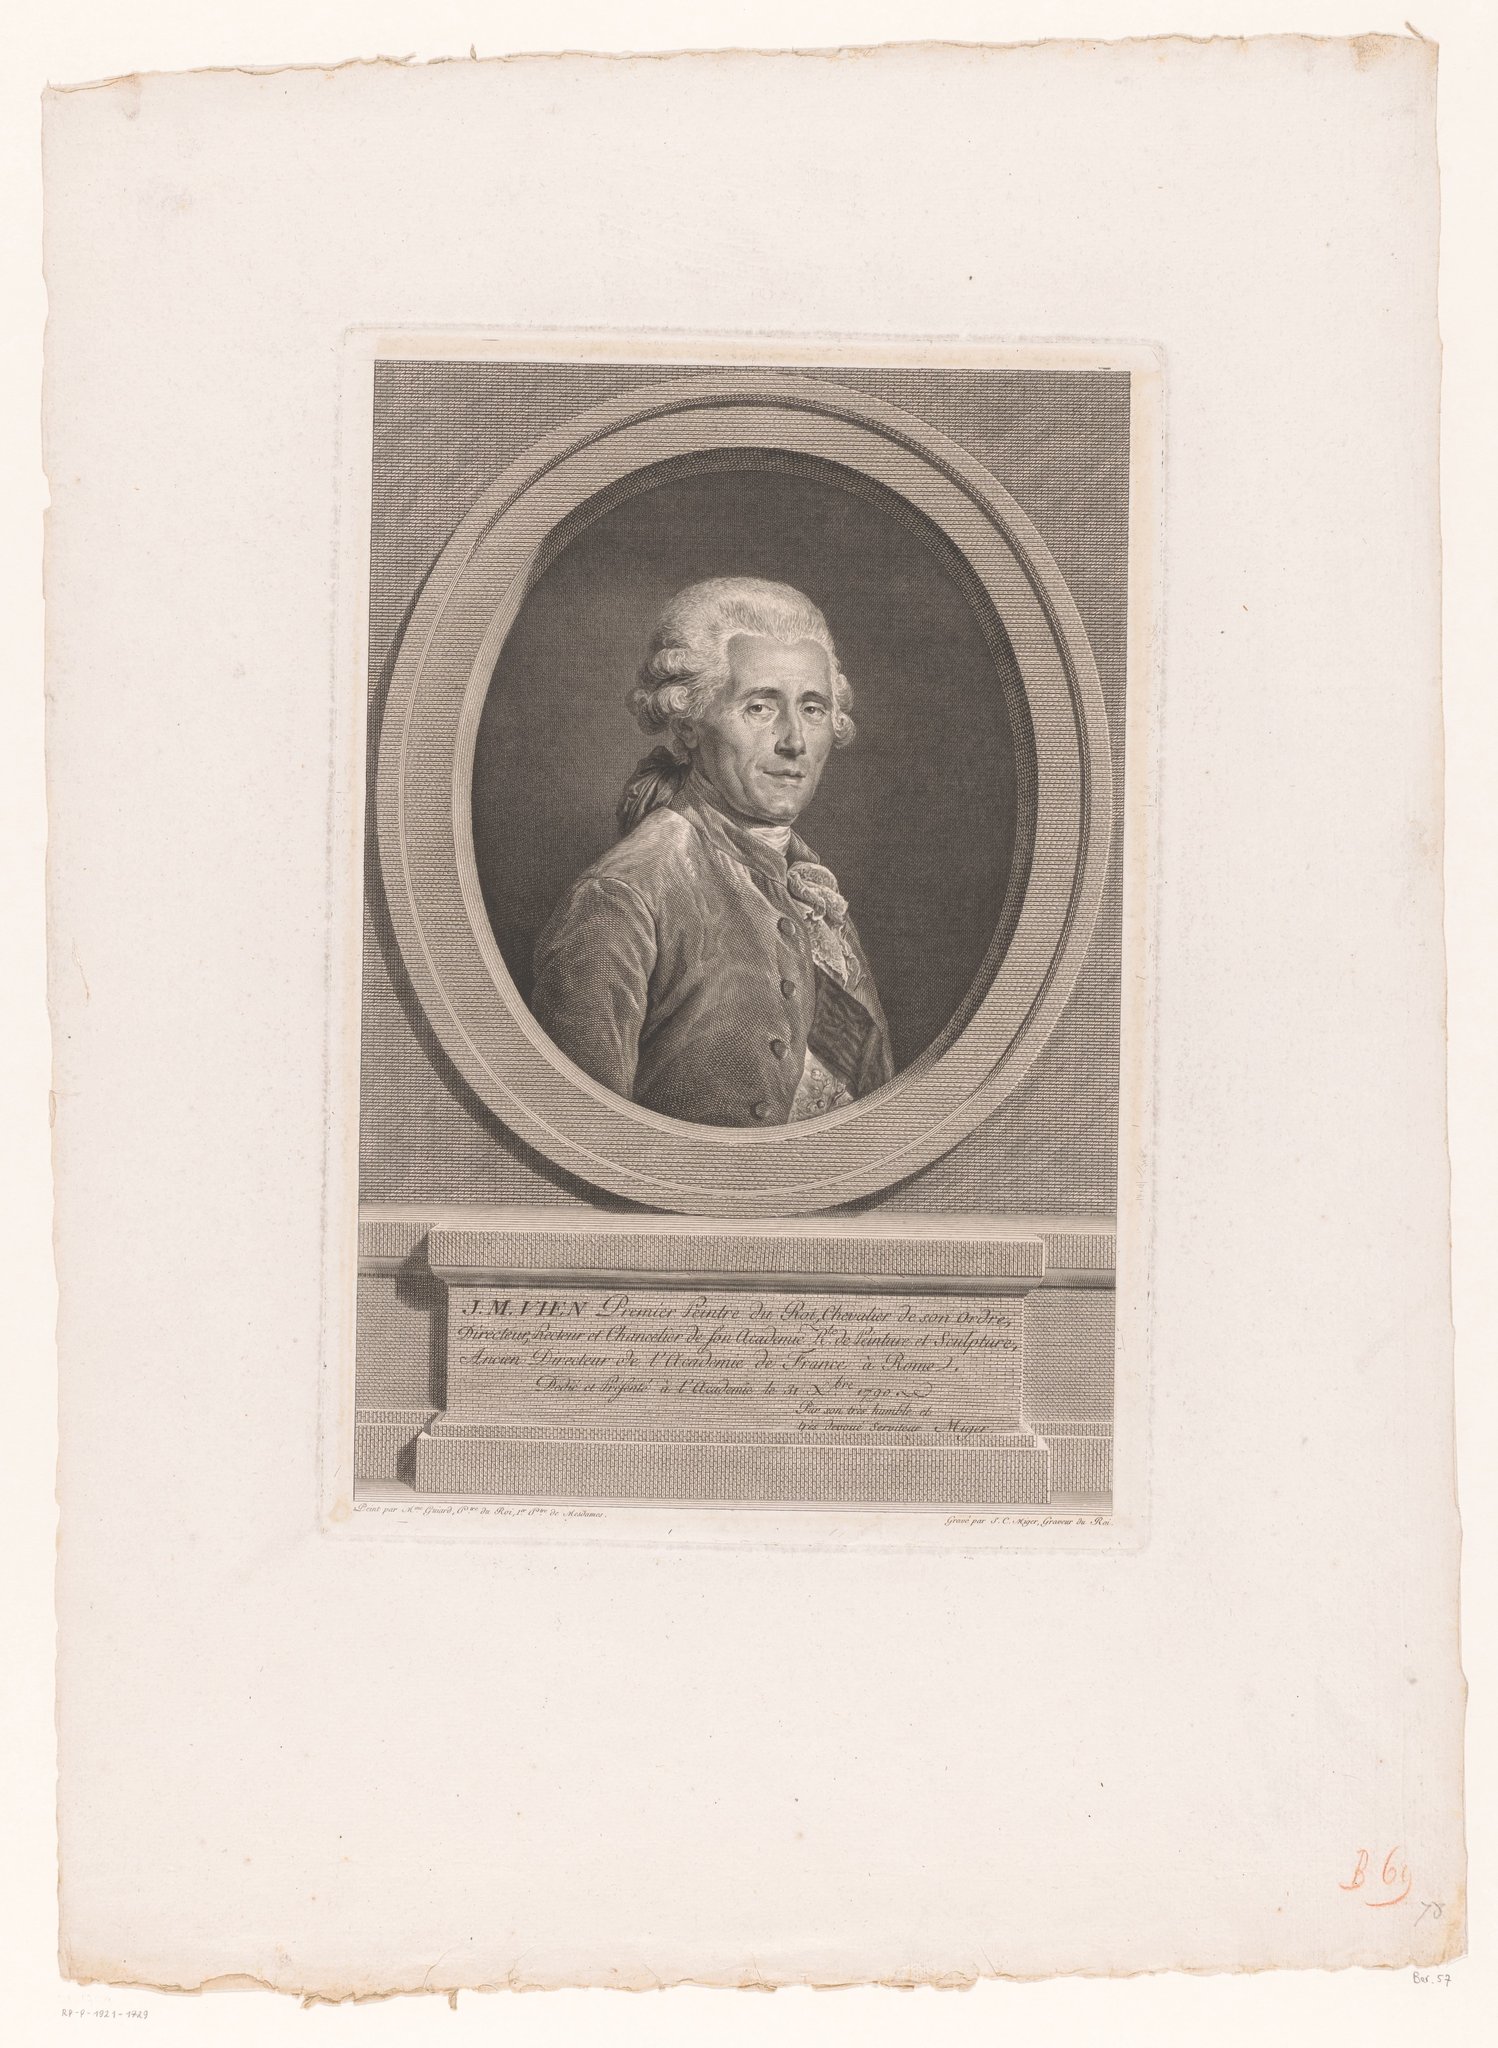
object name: print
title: Portret van Joseph-Marie Vien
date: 1790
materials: paper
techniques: engraving, etching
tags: paris, painter, print maker, joseph-marie vien (i), historical persons, portrait, self-portrait of painter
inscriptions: collector's mark: Lugt 2233